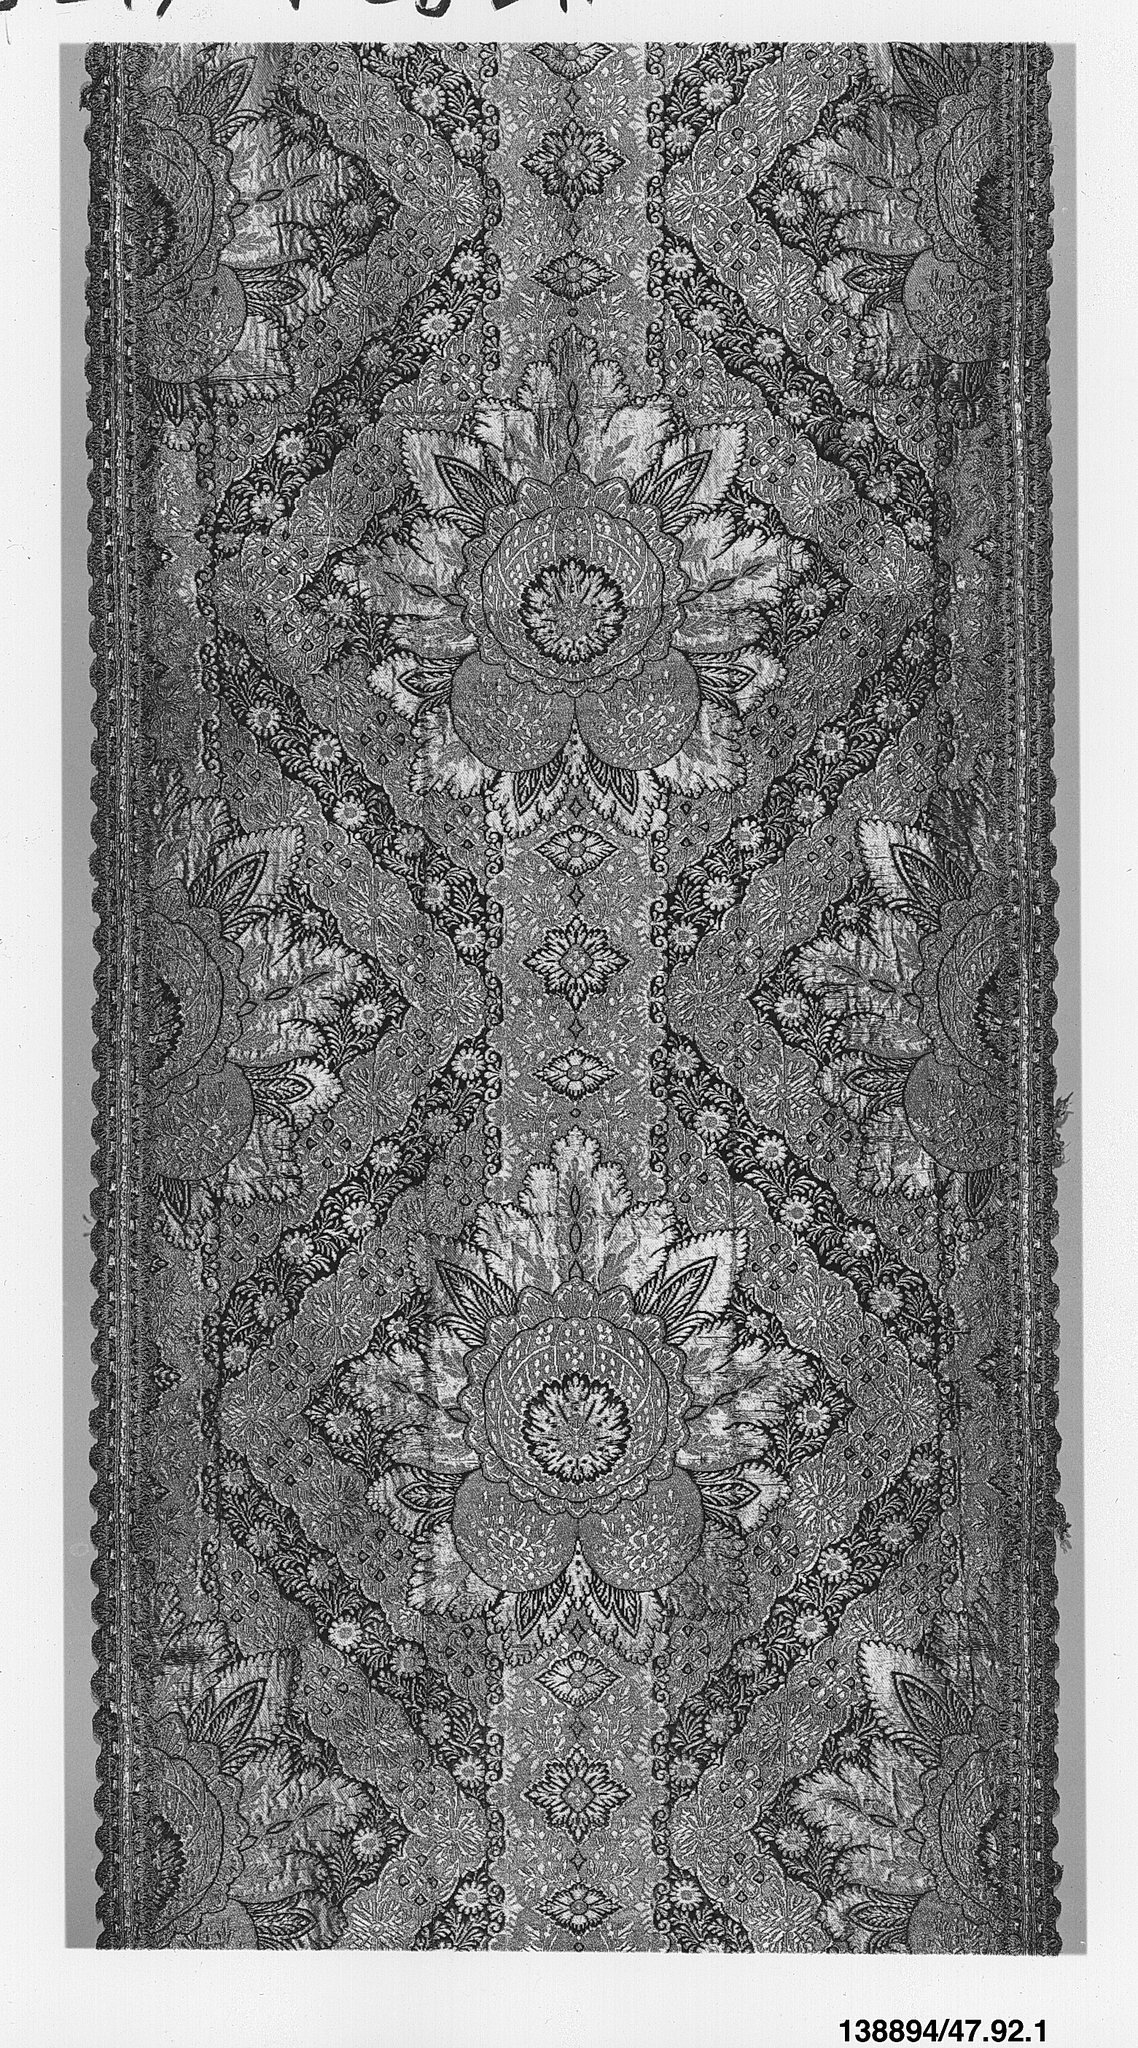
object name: piece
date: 1705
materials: metal thread, silk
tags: flowers,leaves